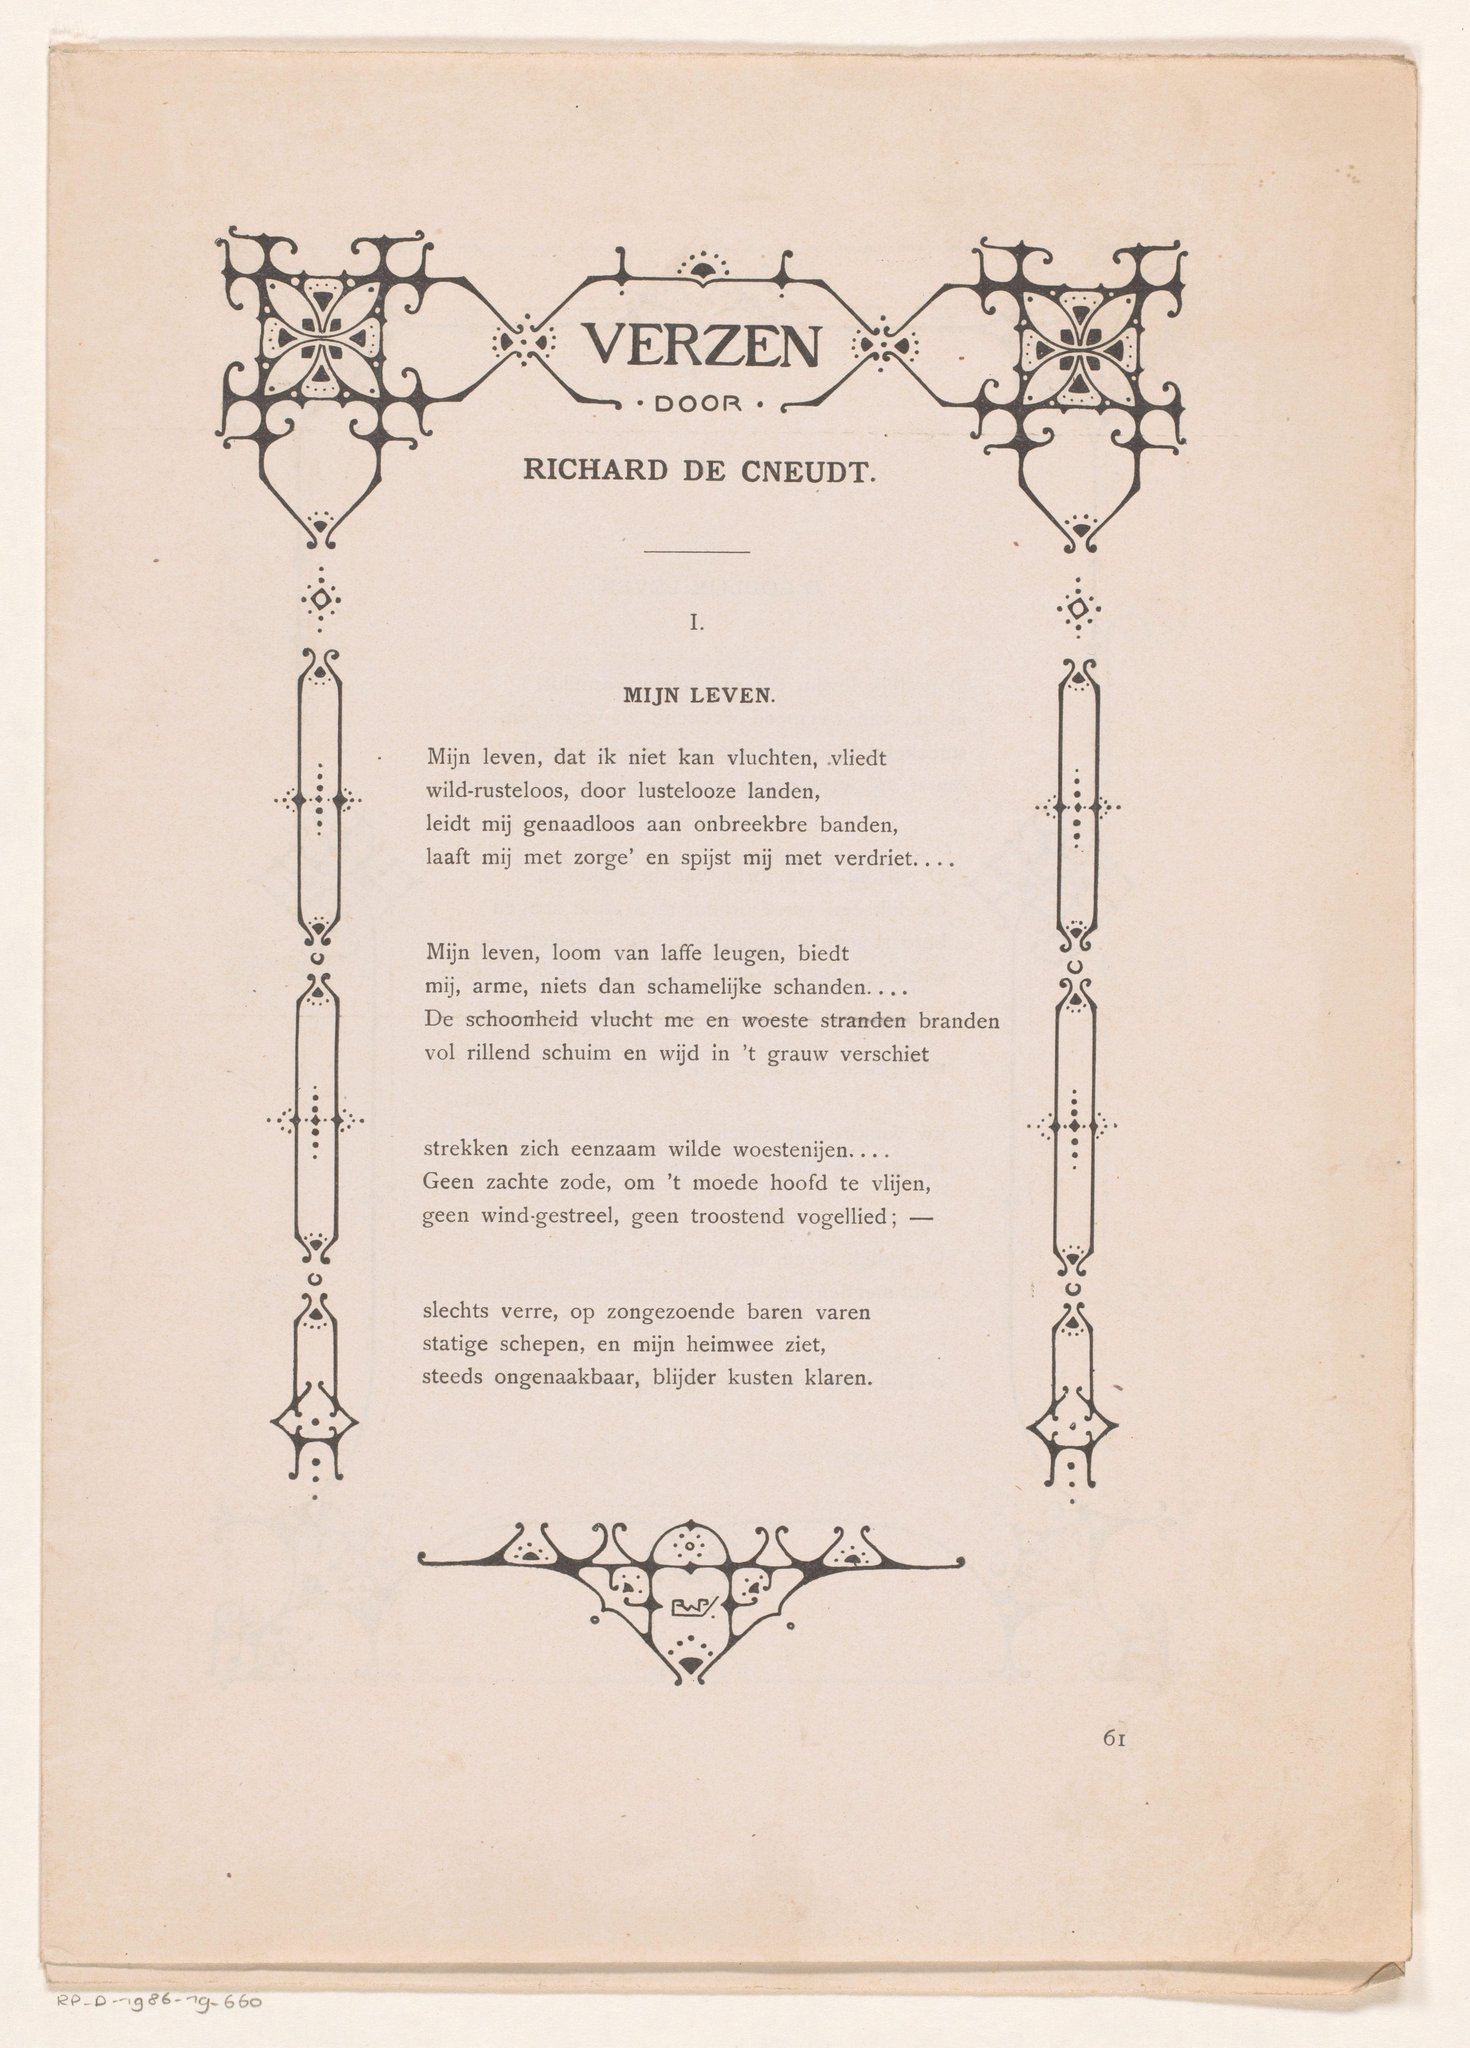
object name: publication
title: Katern uit Elsevier's Geïllustreerd Maandschrift met verzen van Richard de Cneudt en een boekbespreking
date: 1905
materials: paper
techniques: printing block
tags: ornaments ~ art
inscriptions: collector's mark: ‘R:MVS.’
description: De kaders en rubriekshoofden van de publicatie zijn ontworpen door R.W.P. de Vries Jr.